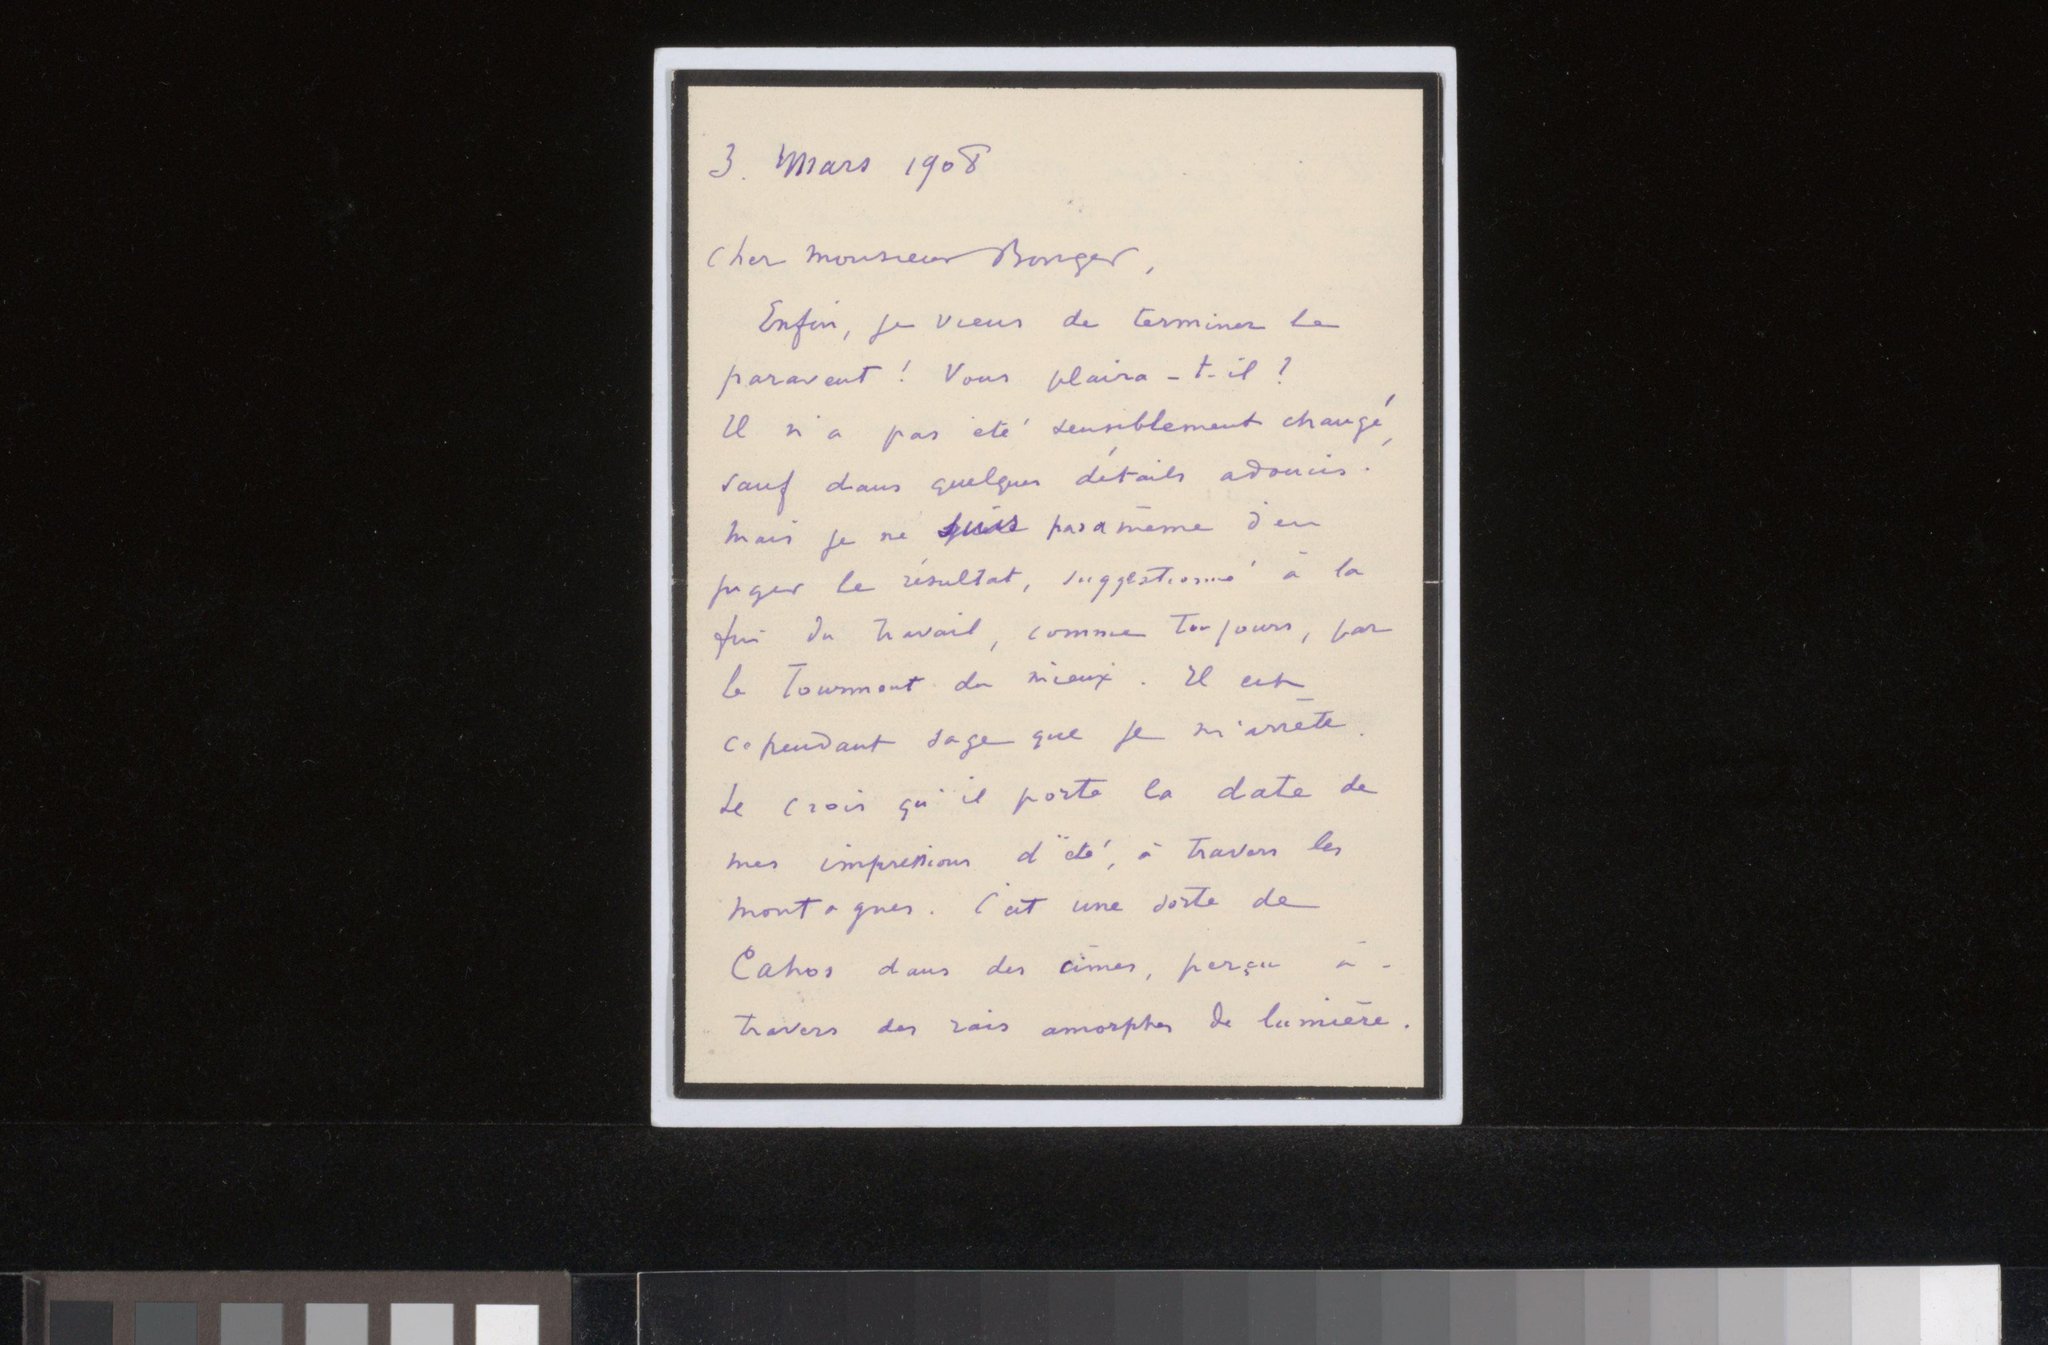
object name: letter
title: Brief aan Andries Bonger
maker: odilon redon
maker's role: draughtsman, painter, print maker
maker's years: 1840-1916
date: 1908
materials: ink, paper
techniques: pen, writing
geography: paris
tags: amsterdam, andries bonger, hector berlioz, applied arts, arts and crafts; industrial design, painting (including book-illumination, miniature-painting), sports, games and physical performances, money, switzerland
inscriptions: watermark